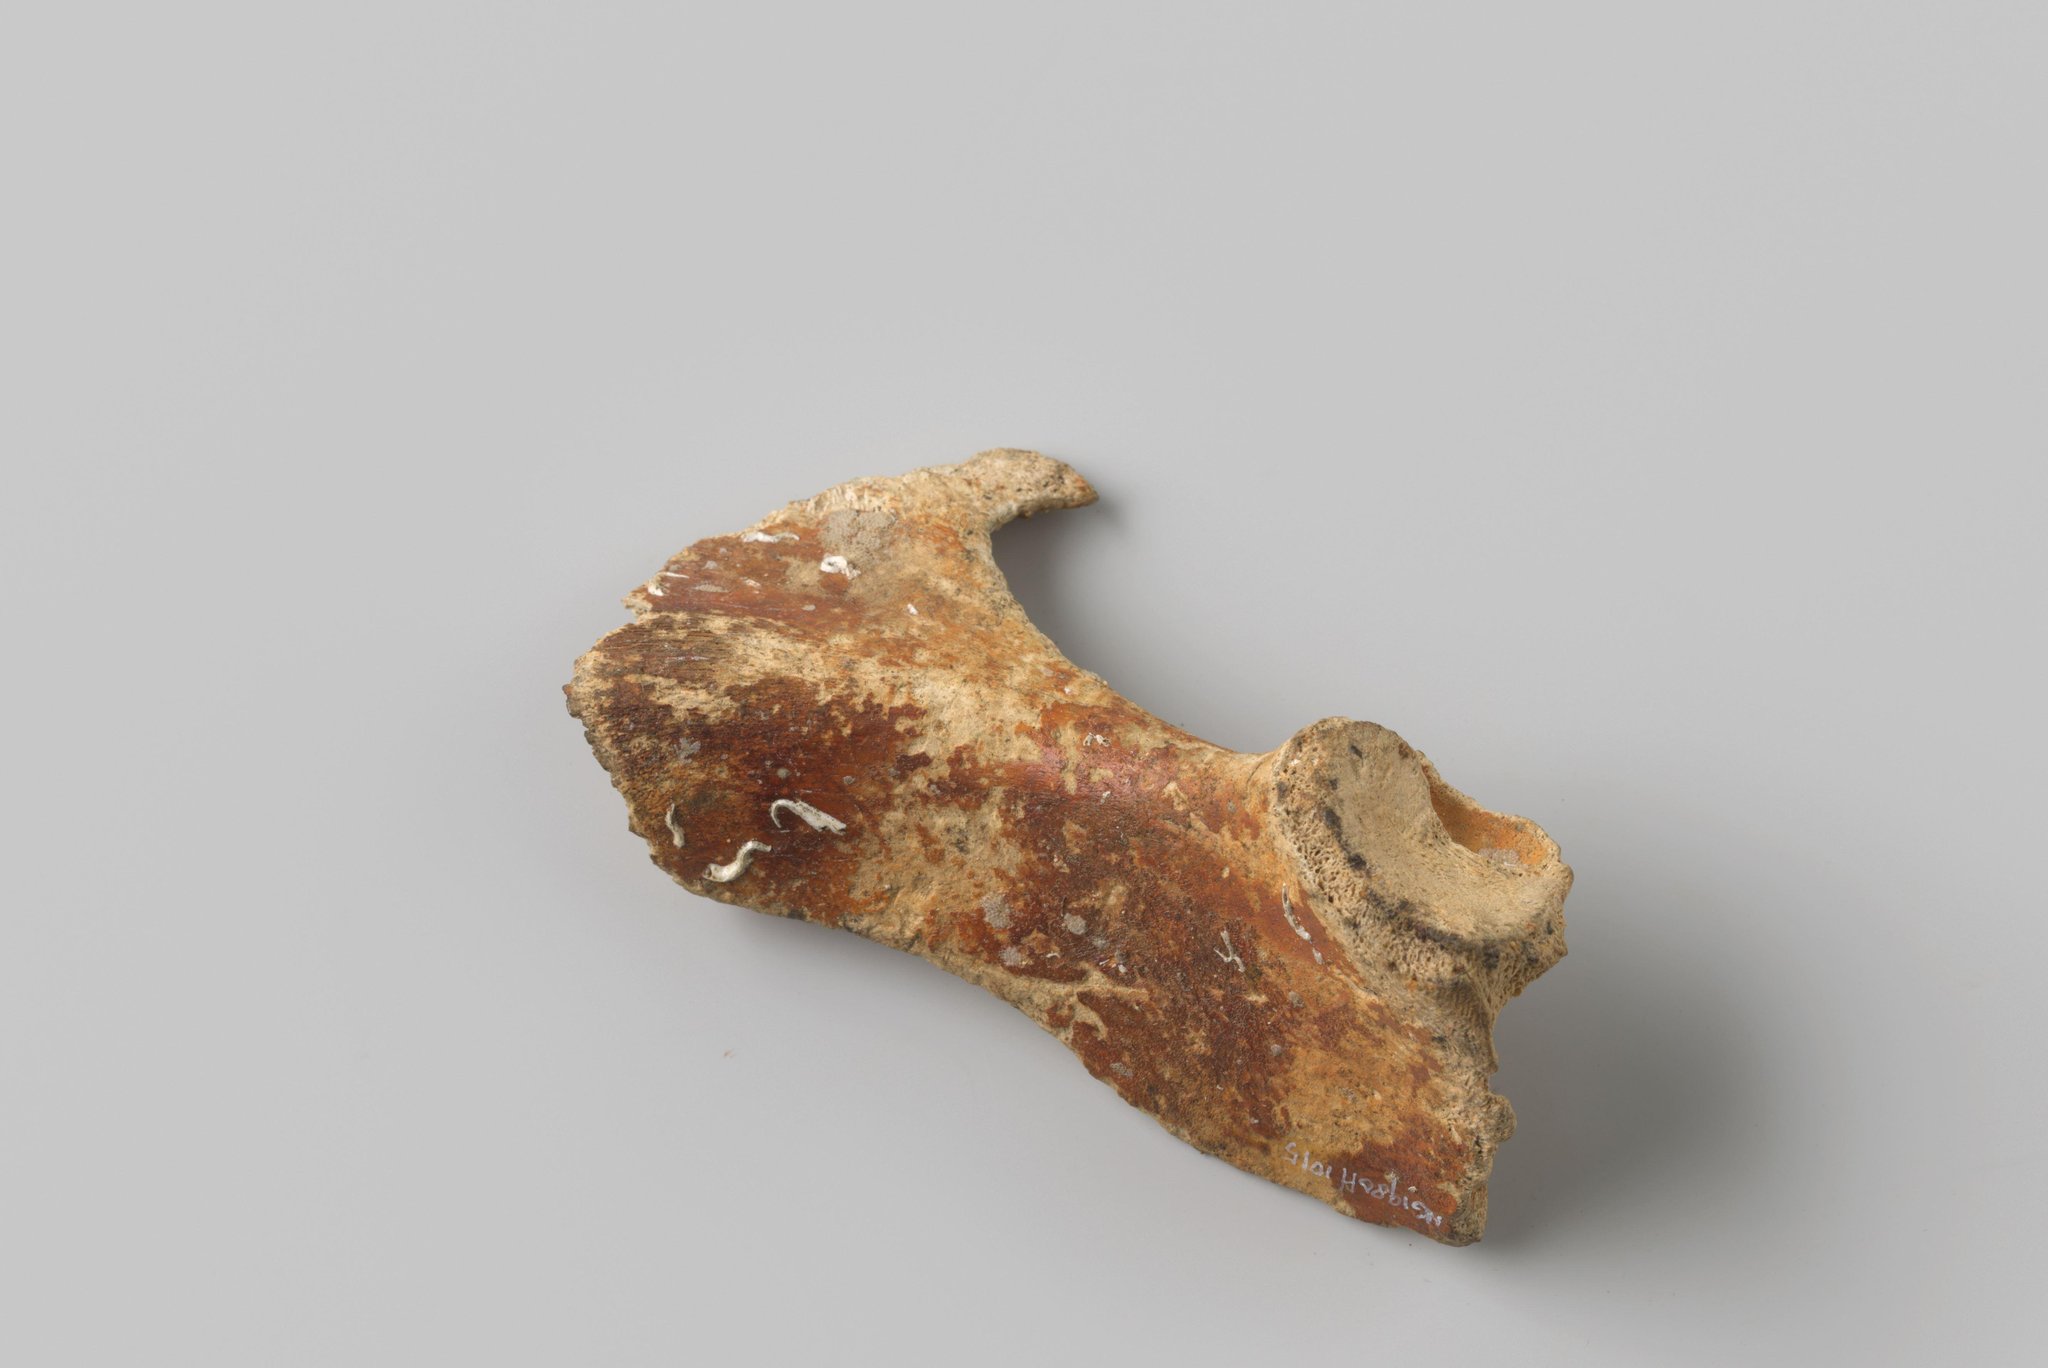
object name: bone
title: Fragment varkensbot uit het wrak van de Oost-Indiëvaarder Hollandia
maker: niet van toepassing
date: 1700-1743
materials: bone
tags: verenigde oostindische compagnie, hollandia (schip), annet